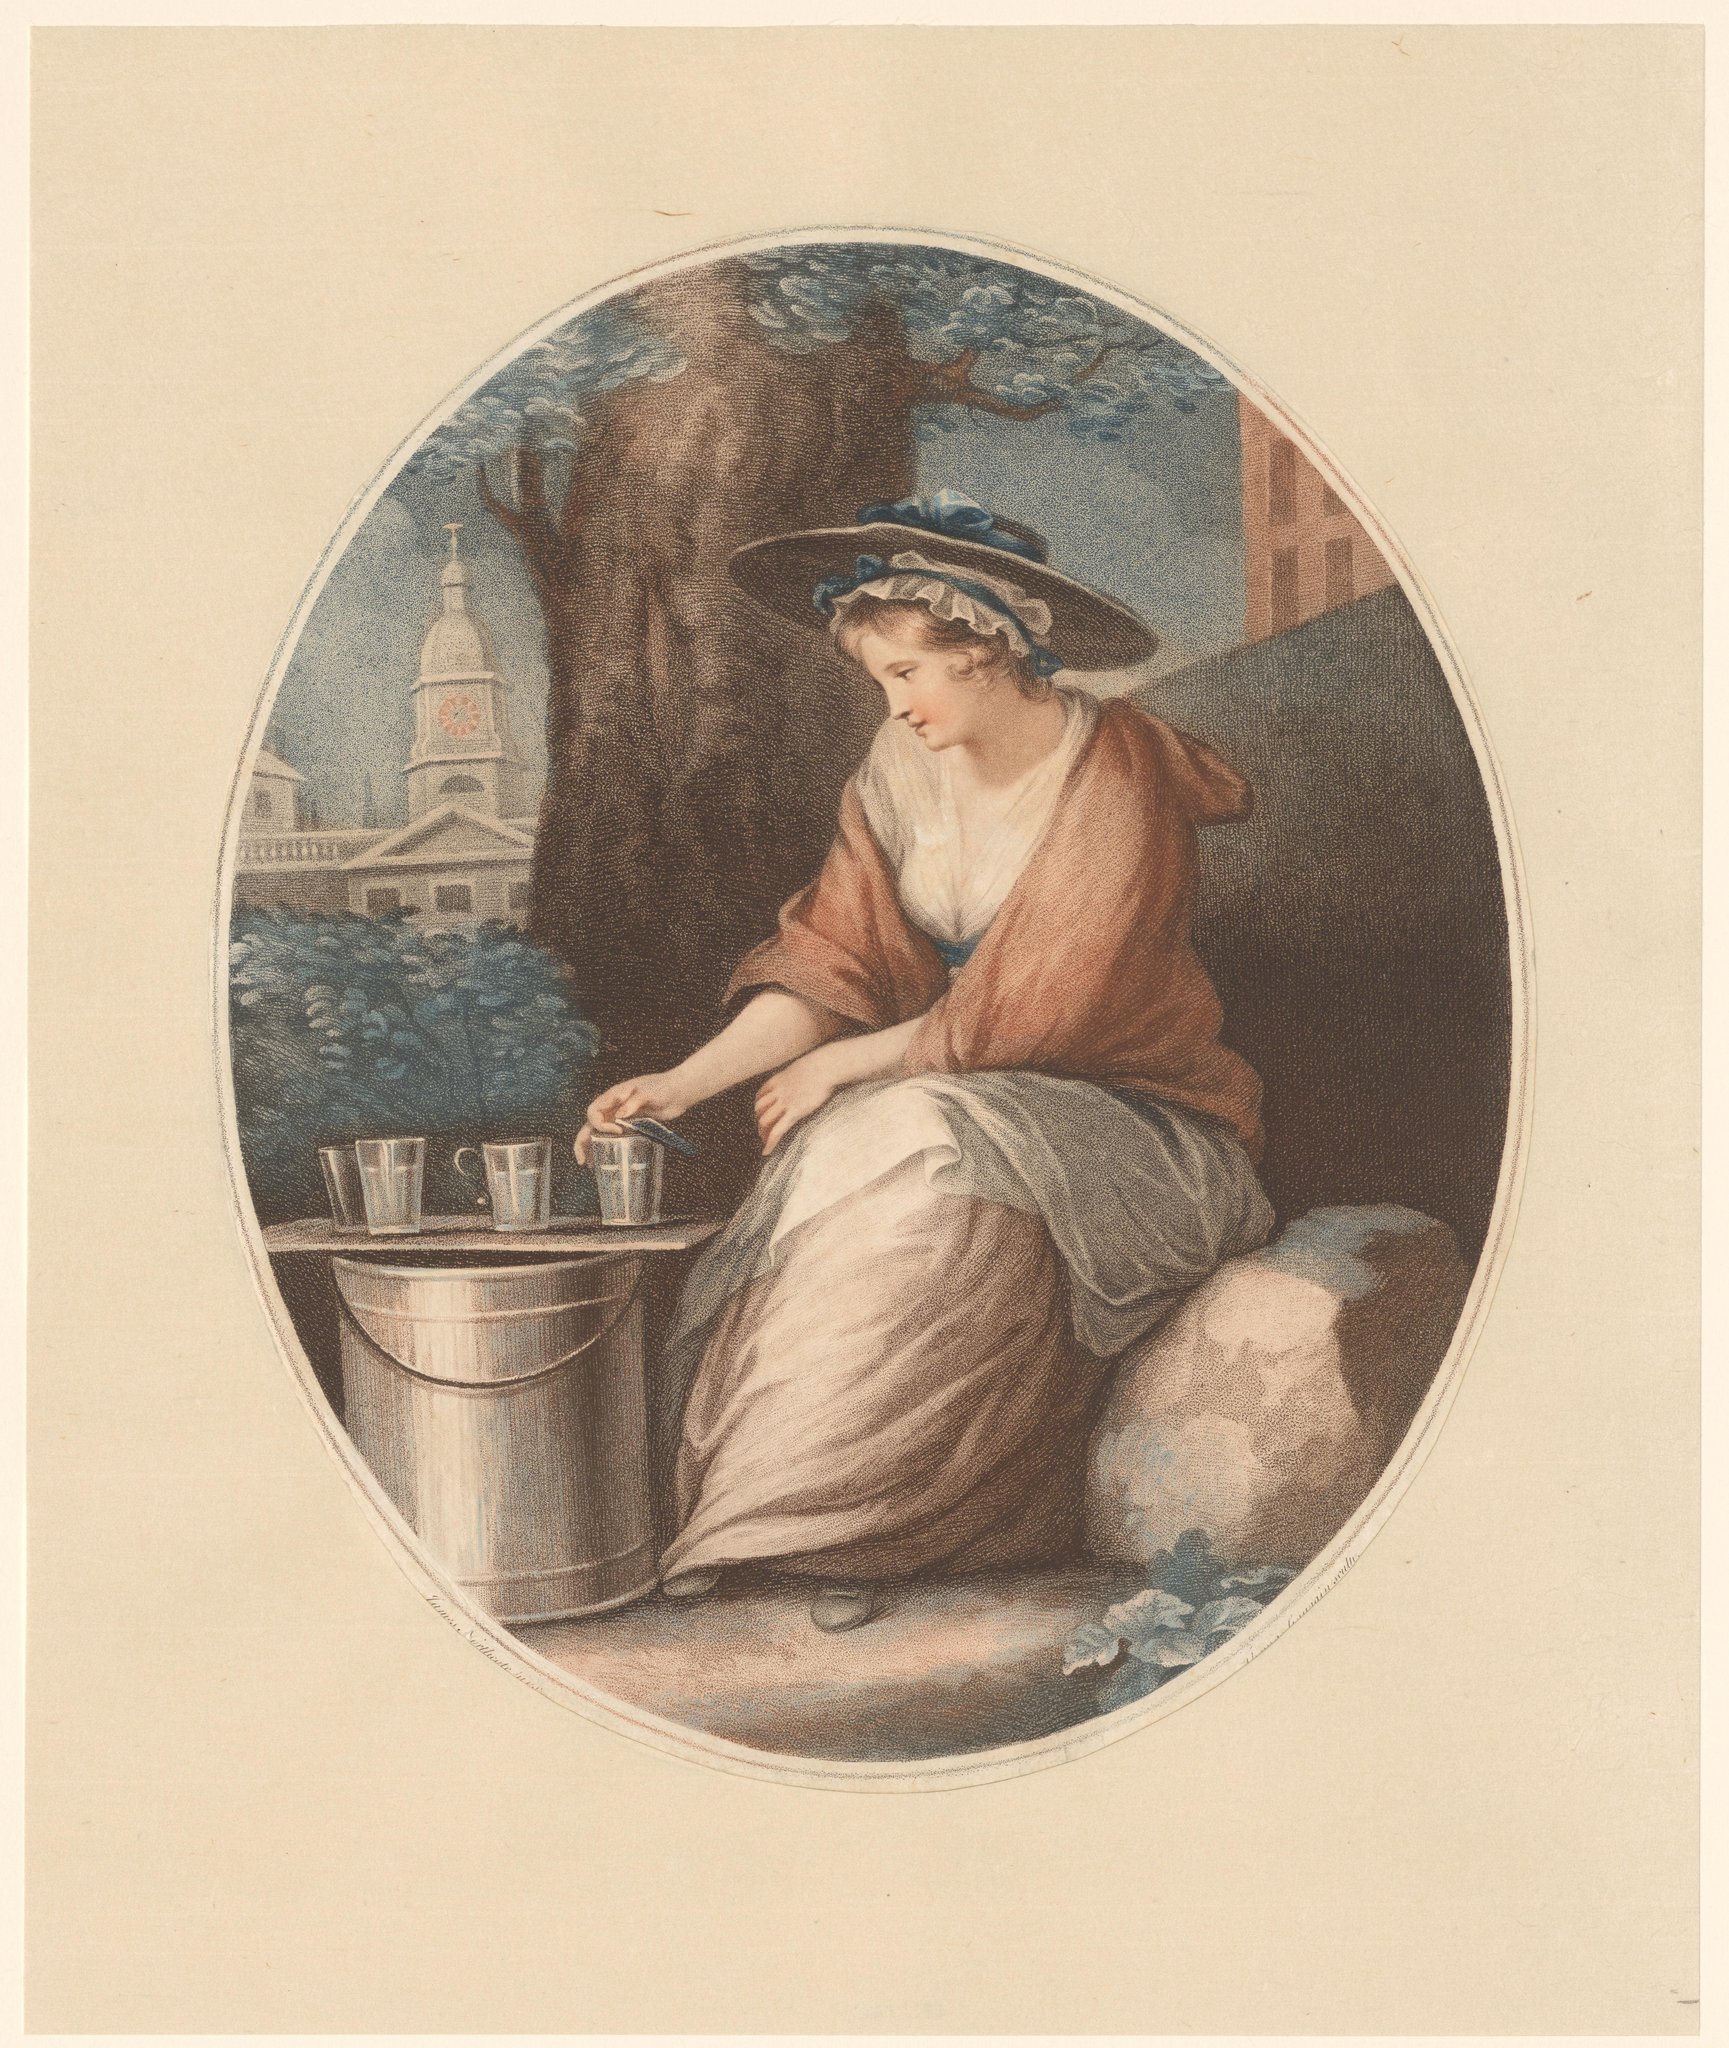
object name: print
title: Jonge vrouw bij een boom gezeten met vier glazen melk op een blad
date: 1766-1810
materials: paper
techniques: hand coloring, lithography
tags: adolescent, young woman, maiden, milk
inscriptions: collector's mark: Lugt 2228, collector's mark: Lugt 2760